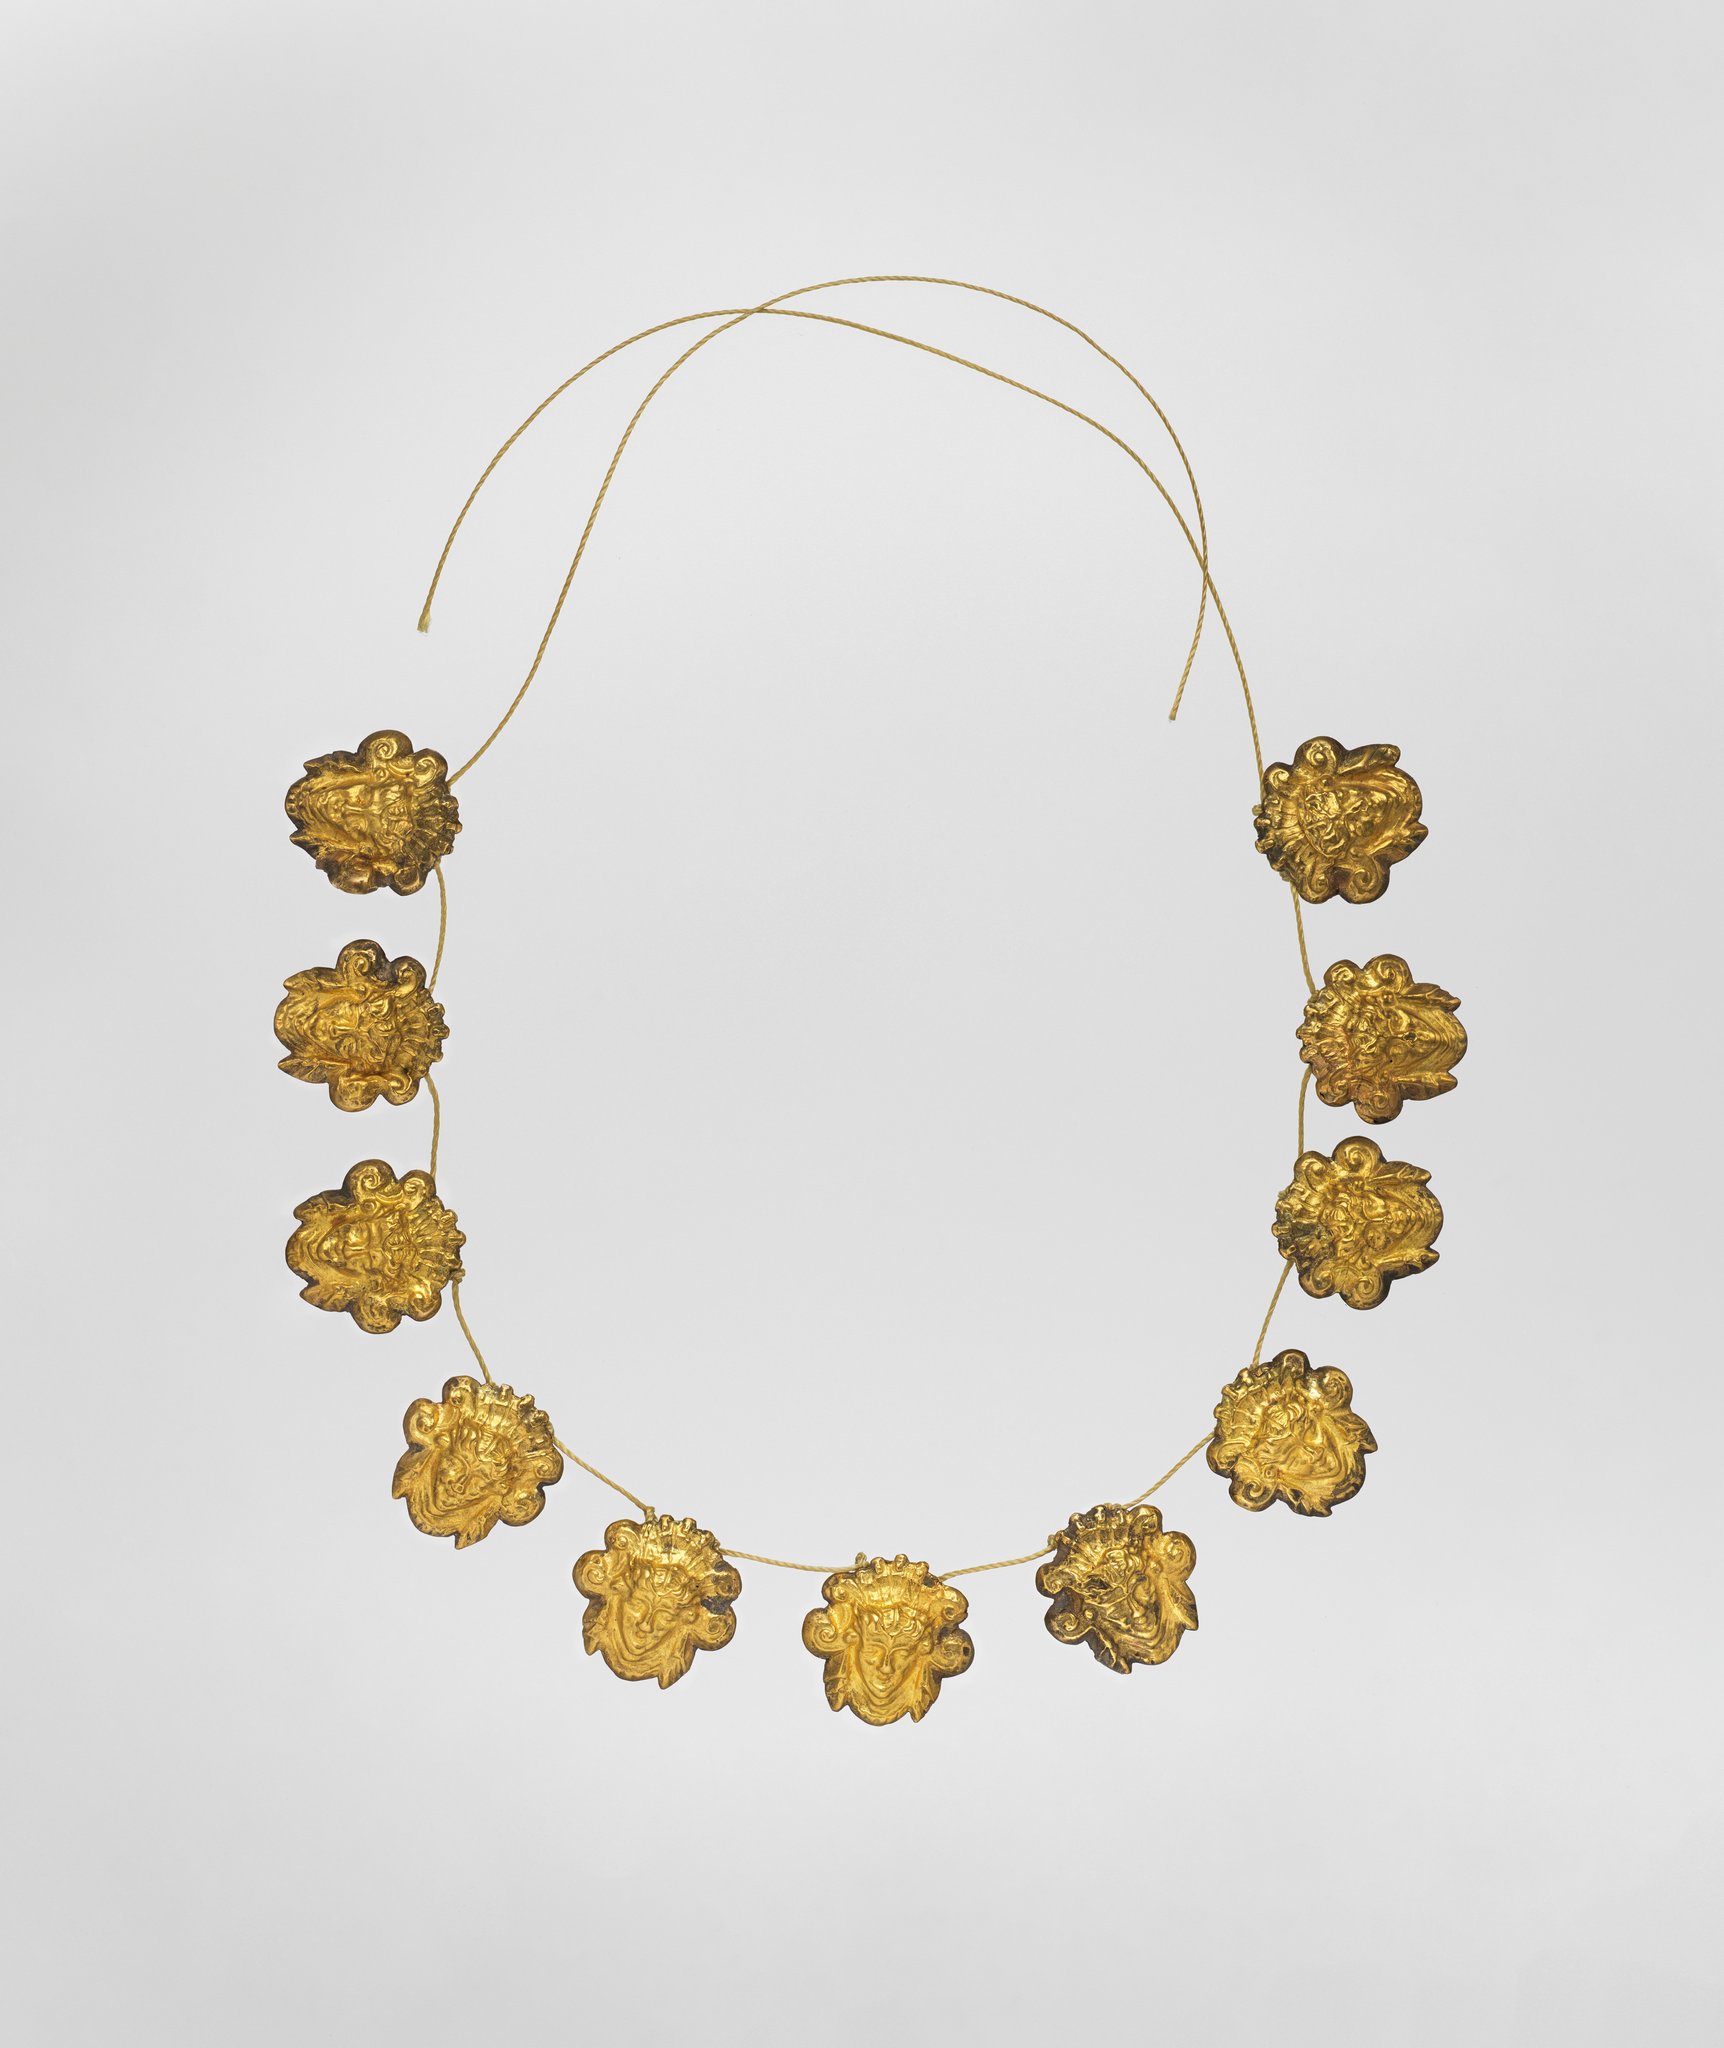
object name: pendant, head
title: Group of 11 Pendant Heads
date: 332-330 BCE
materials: gold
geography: egypt